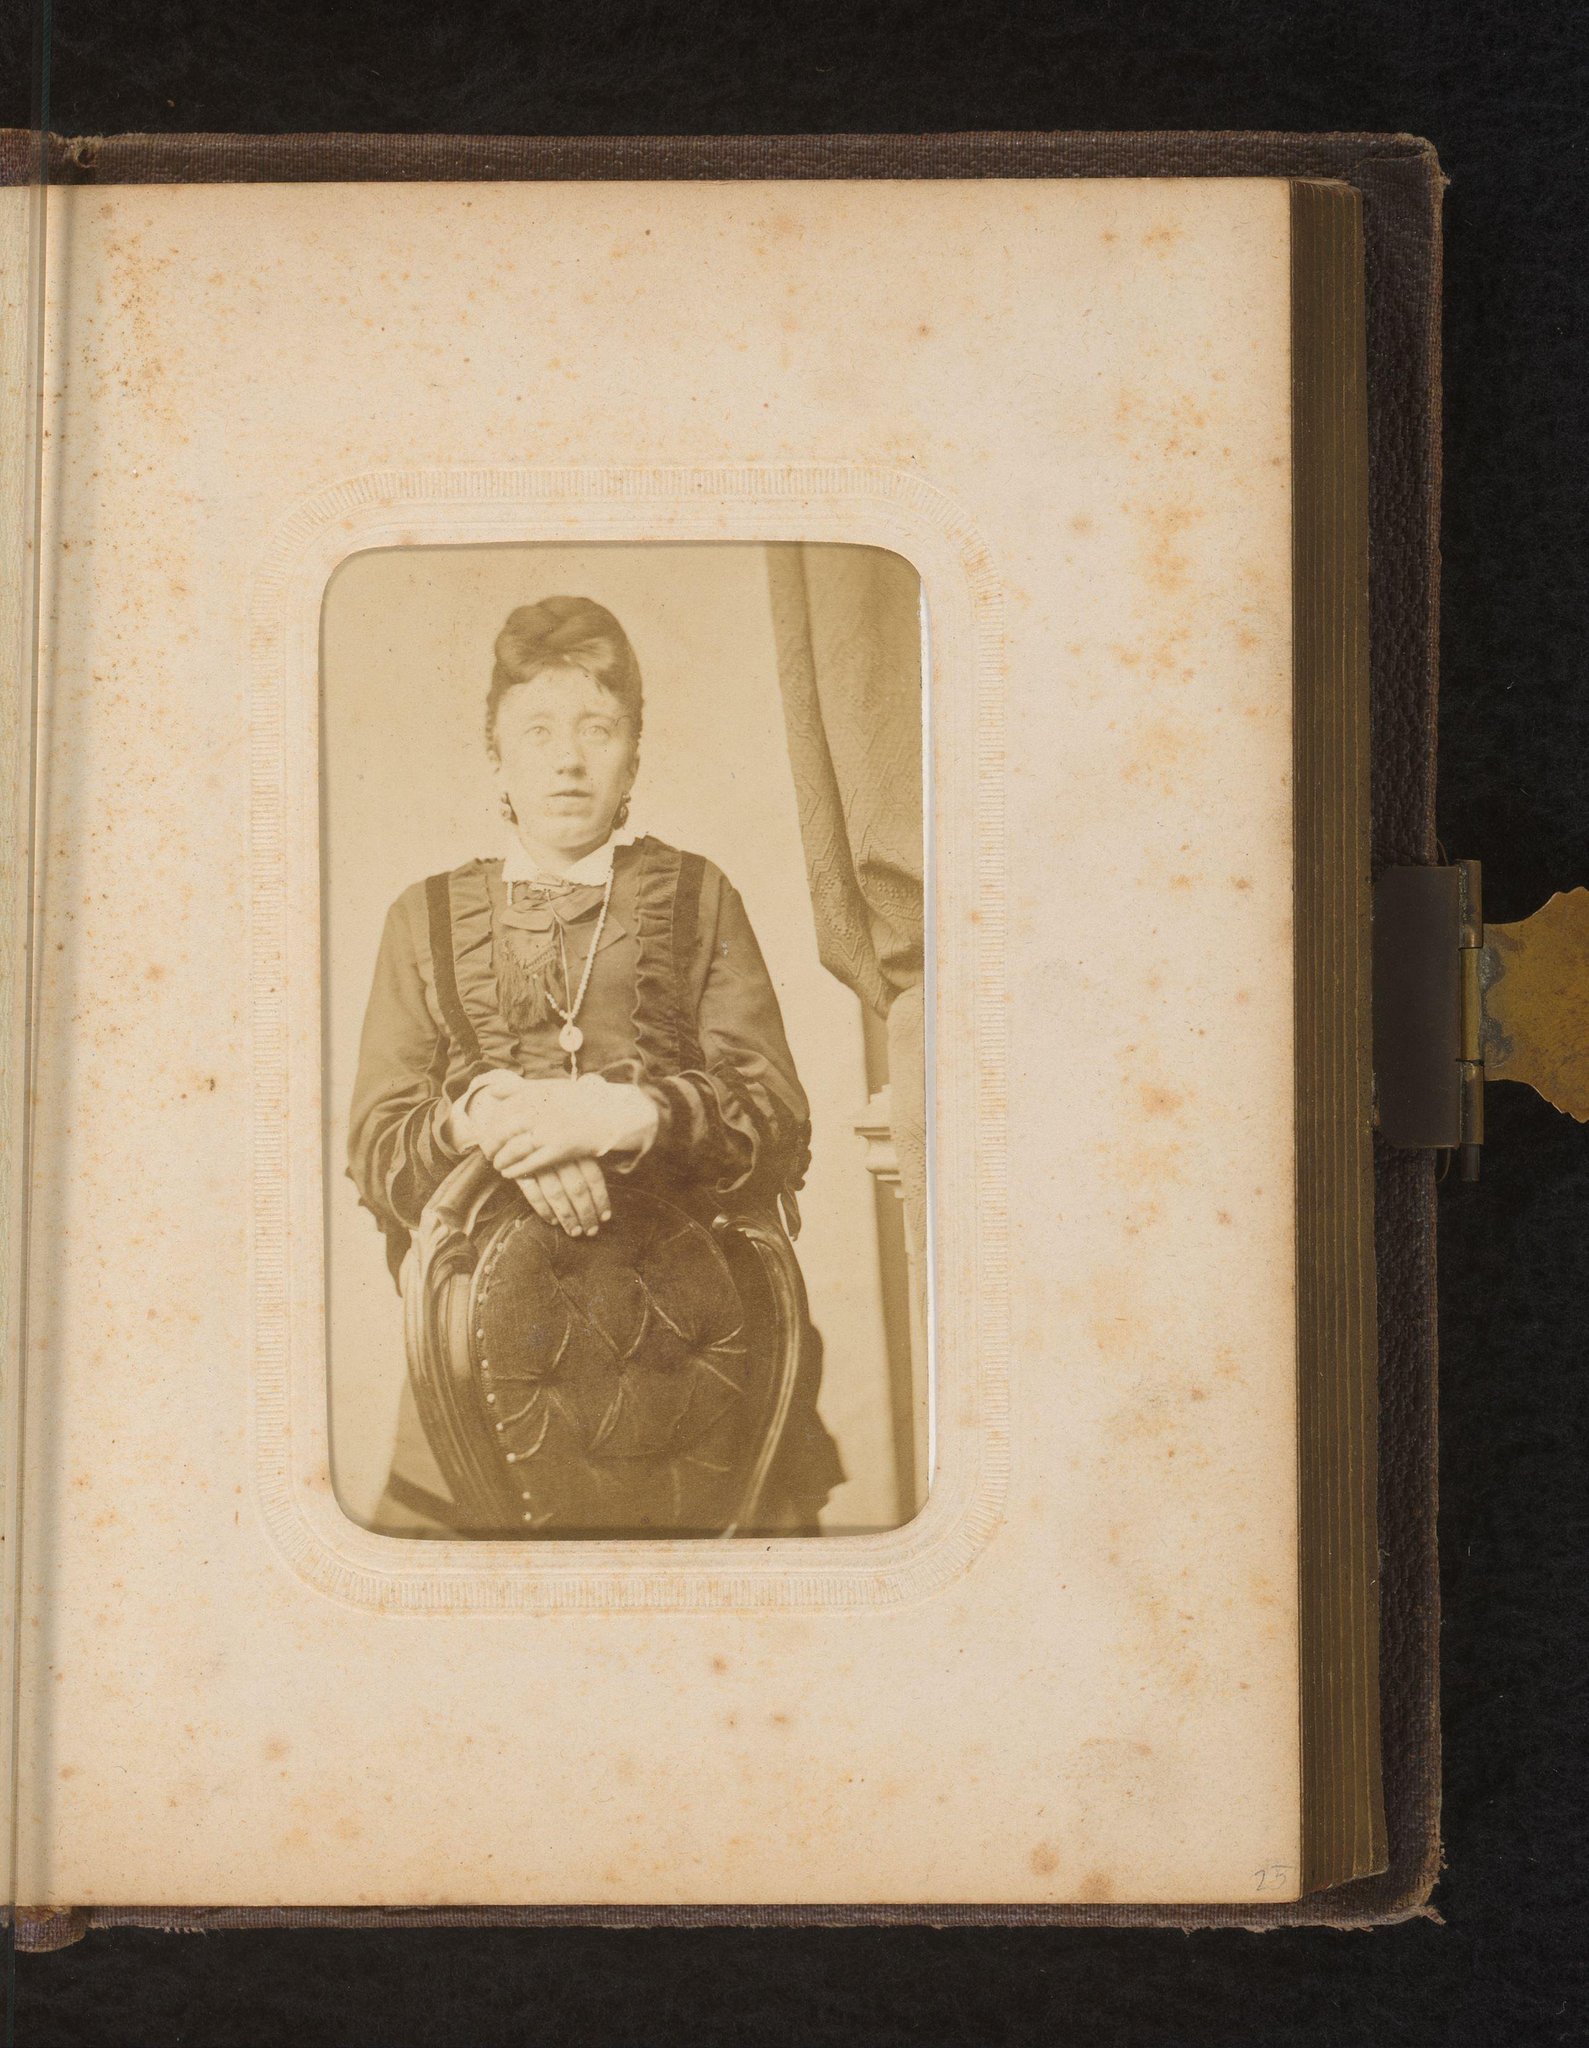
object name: album leaf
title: Portret van een staande vrouw bij een stoel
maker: valentin joan frescarode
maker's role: fotograaf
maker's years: 1824-1903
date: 1860-1886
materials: cardboard, photographic support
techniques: albumen print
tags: historical persons, standing figure - aa - female human figure, chair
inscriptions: inscription: ‘Photographisch/ Atelier/ V. Jean Frescarode/ Firma W.H.A. Kampfraat/ Spiegelstraat/ bij de Kerkstraat CC 42/ Amsterdam’